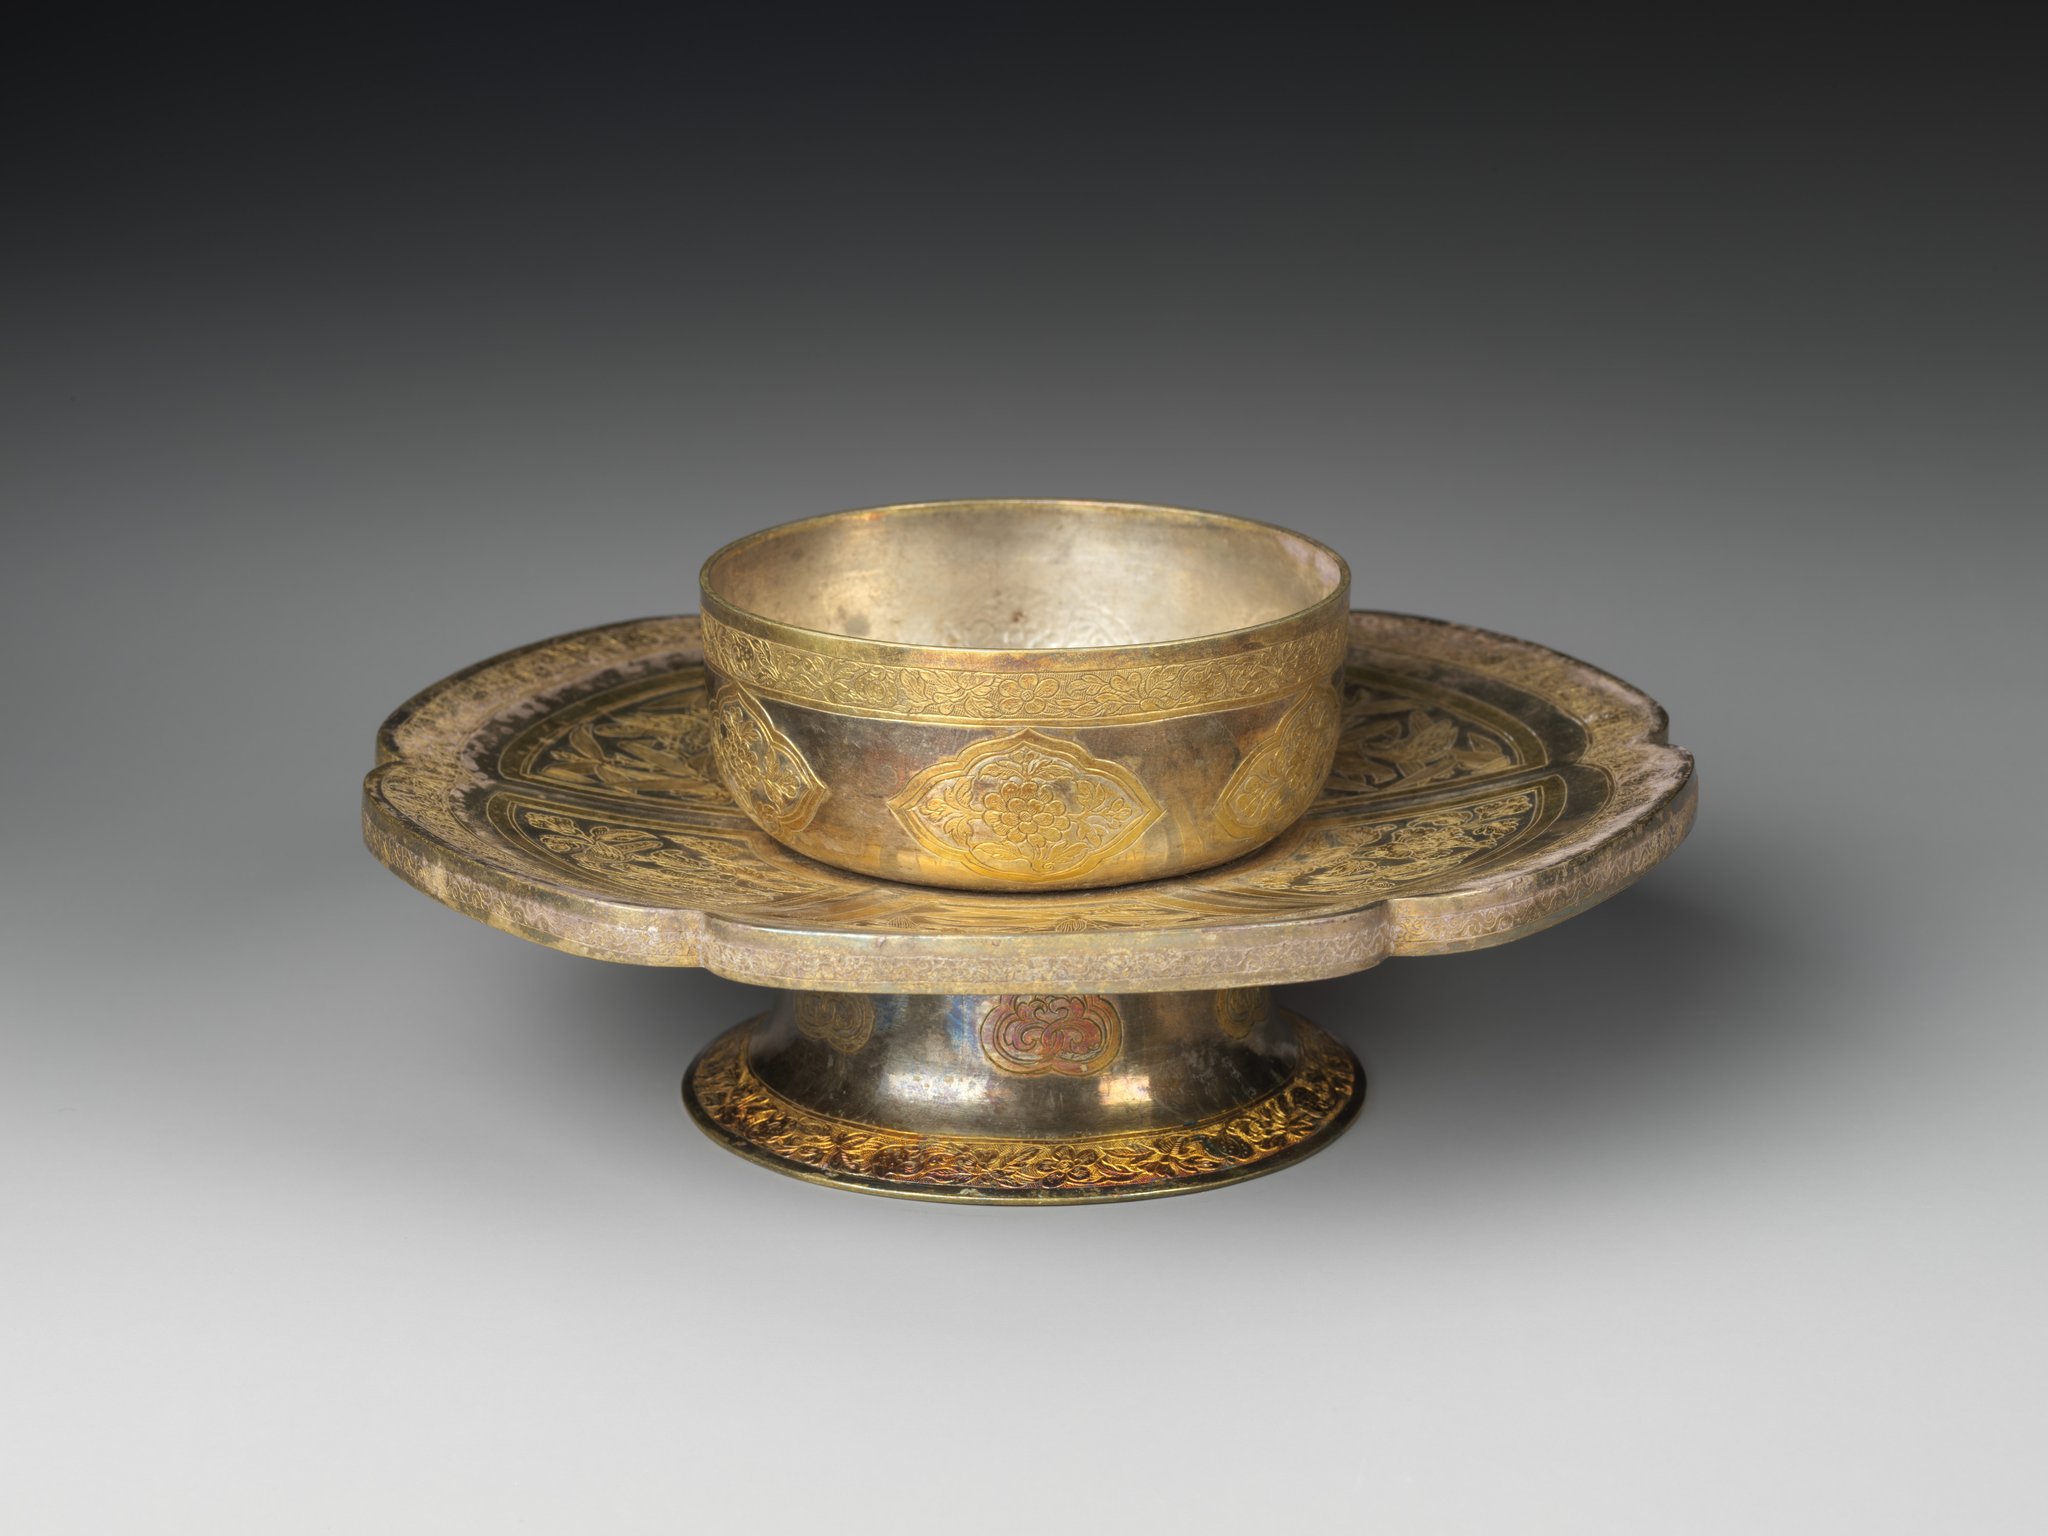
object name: bowl and stand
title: Lobed bowl stand with flowers and birds (one from a set)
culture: chinese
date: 1267-1400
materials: silver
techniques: chasing, gilding